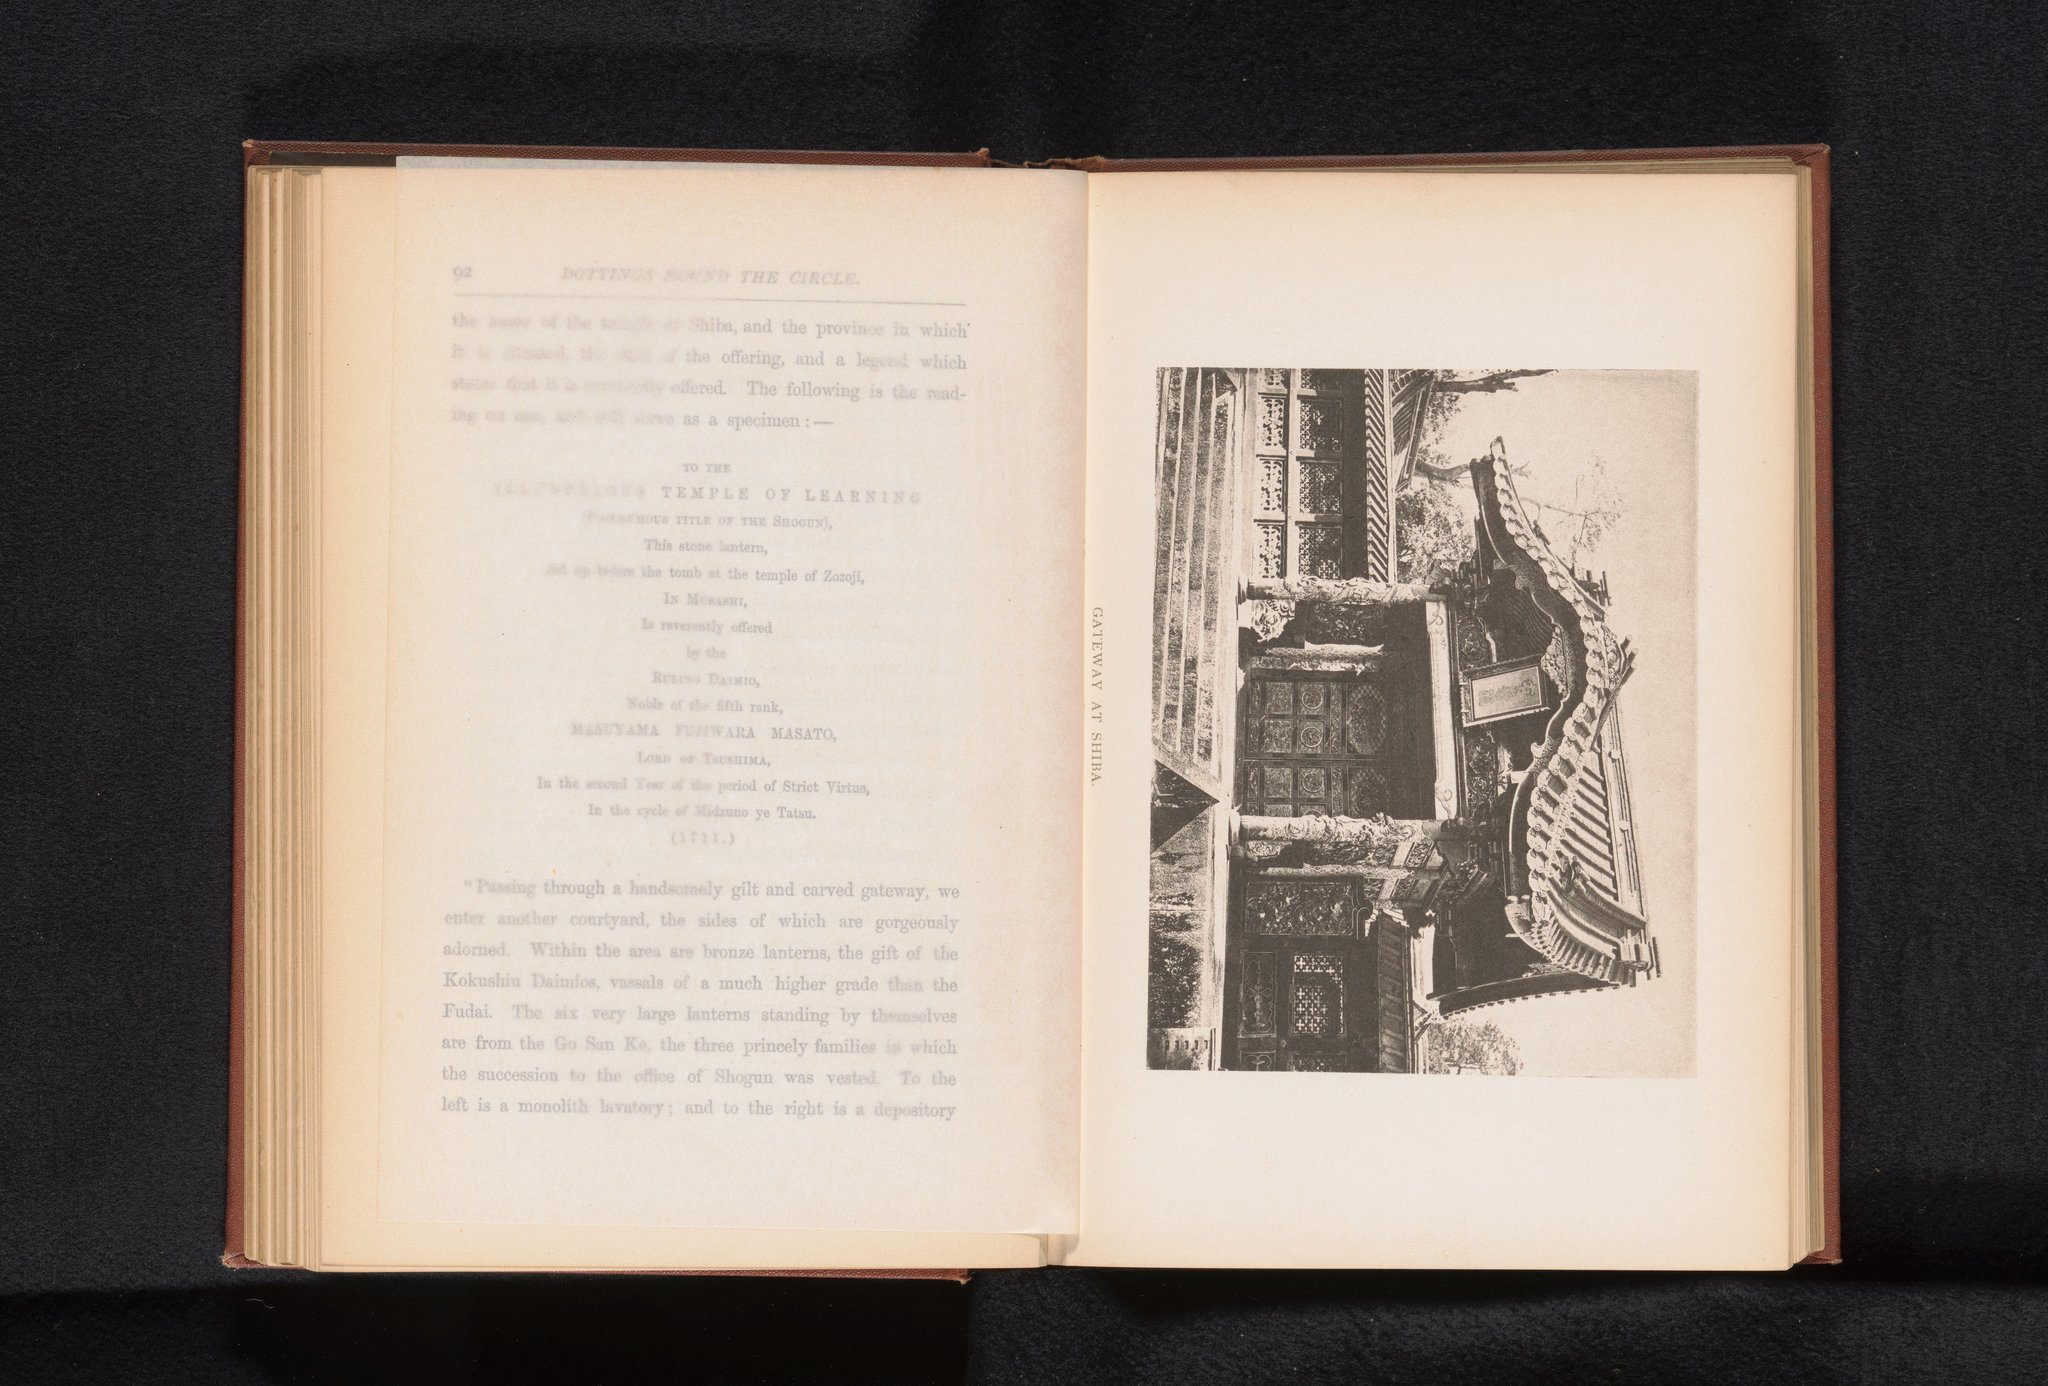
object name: page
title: Gezicht op een poort in Shiba in Tokyo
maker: Anonymous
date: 1866-1876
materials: paper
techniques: photoaquatint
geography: tokyo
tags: gate, entrance